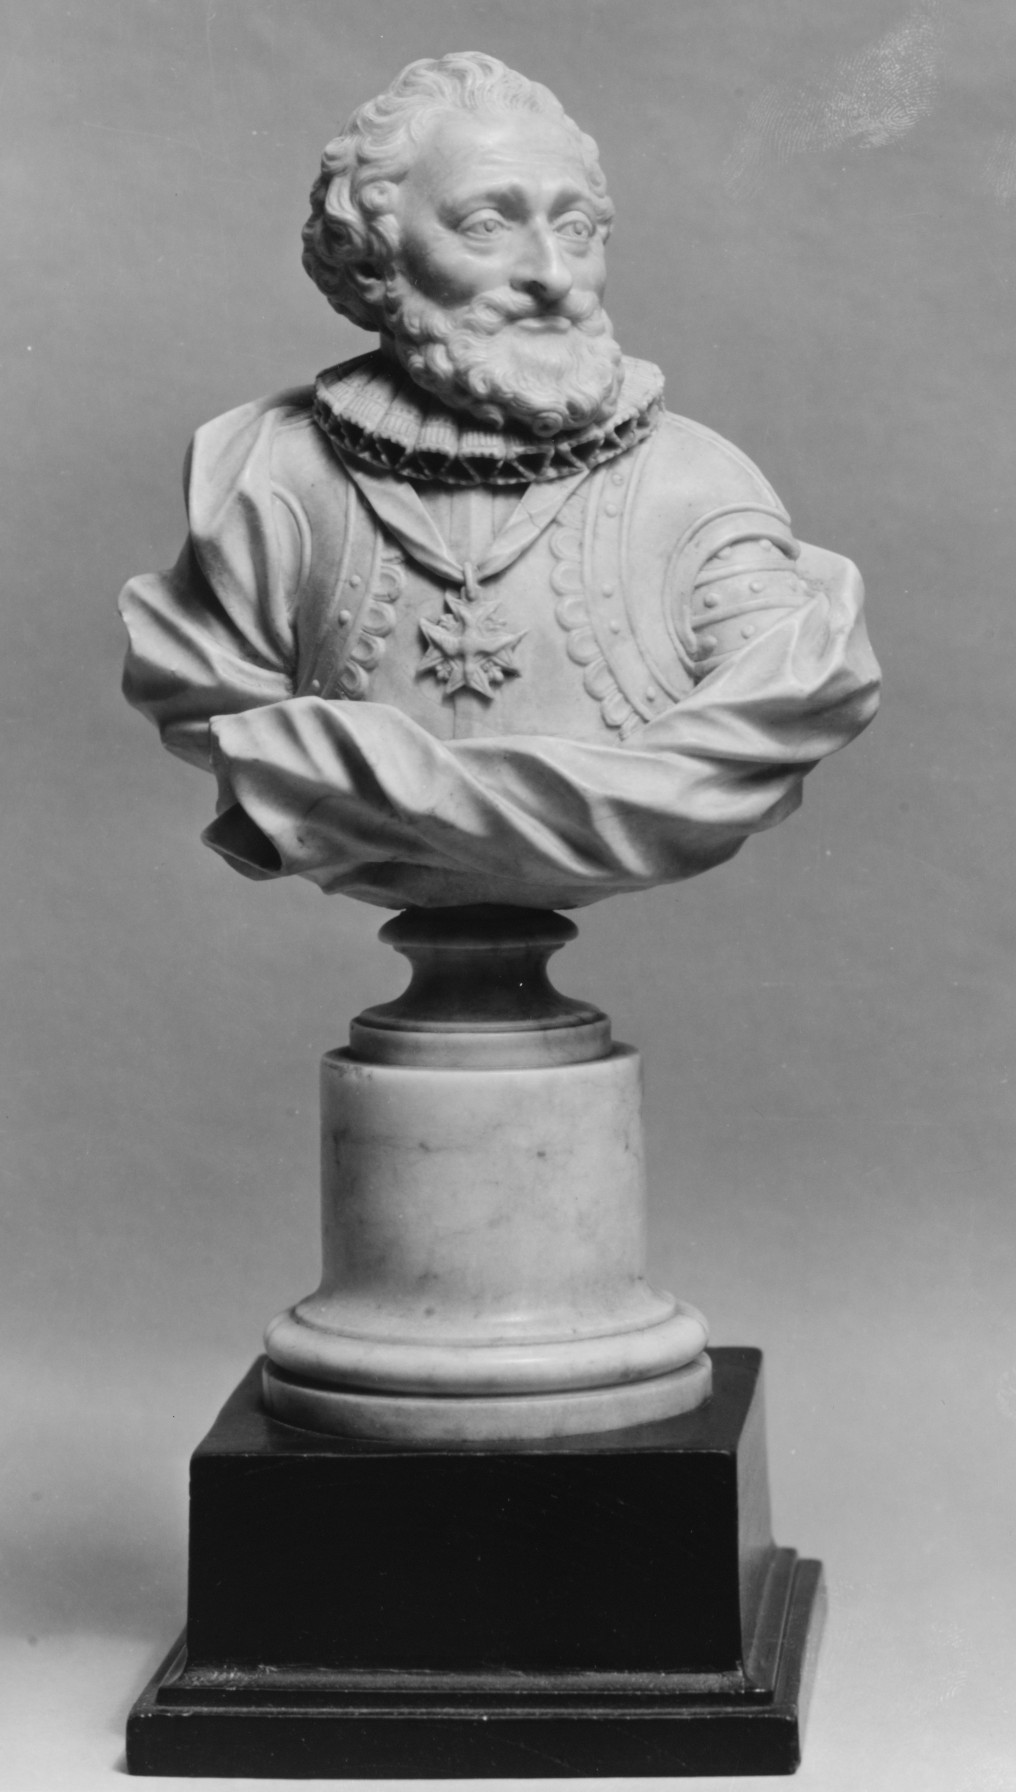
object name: bust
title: Henry IV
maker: jean-claude-françois-joseph rosset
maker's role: artist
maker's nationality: french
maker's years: 1706-1786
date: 1701-1800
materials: marble, wood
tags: kings,portraits